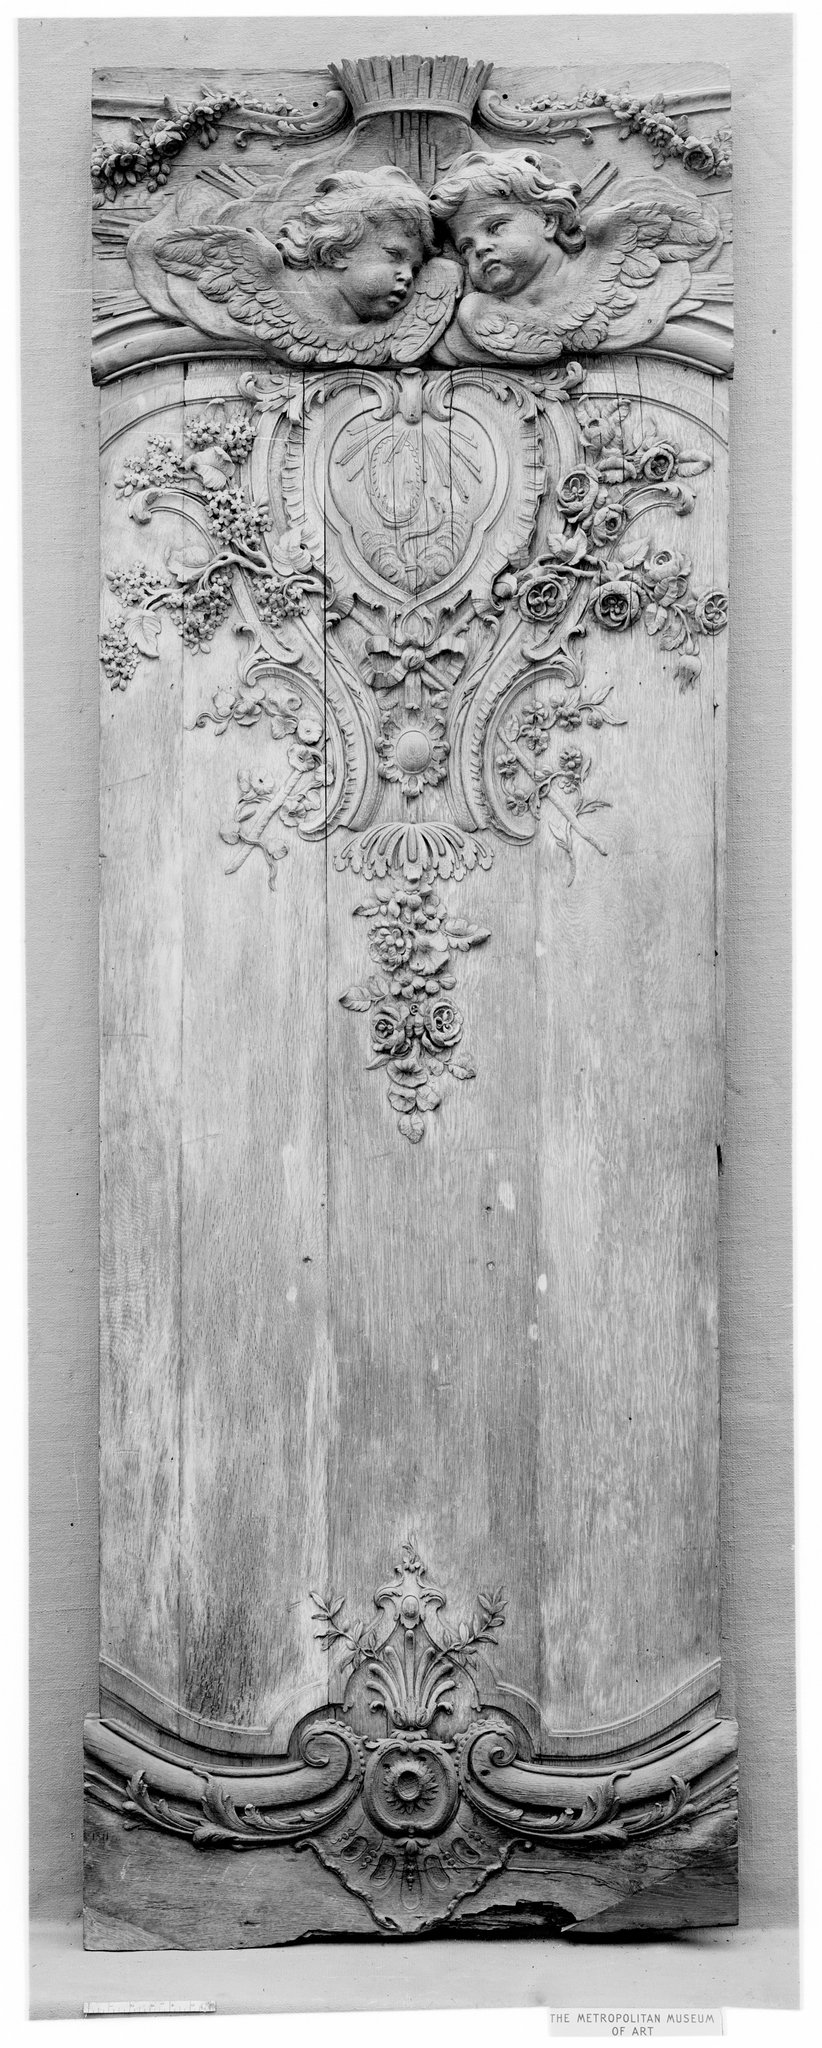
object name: panel fragment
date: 1701-1733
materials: wood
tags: faces,flowers